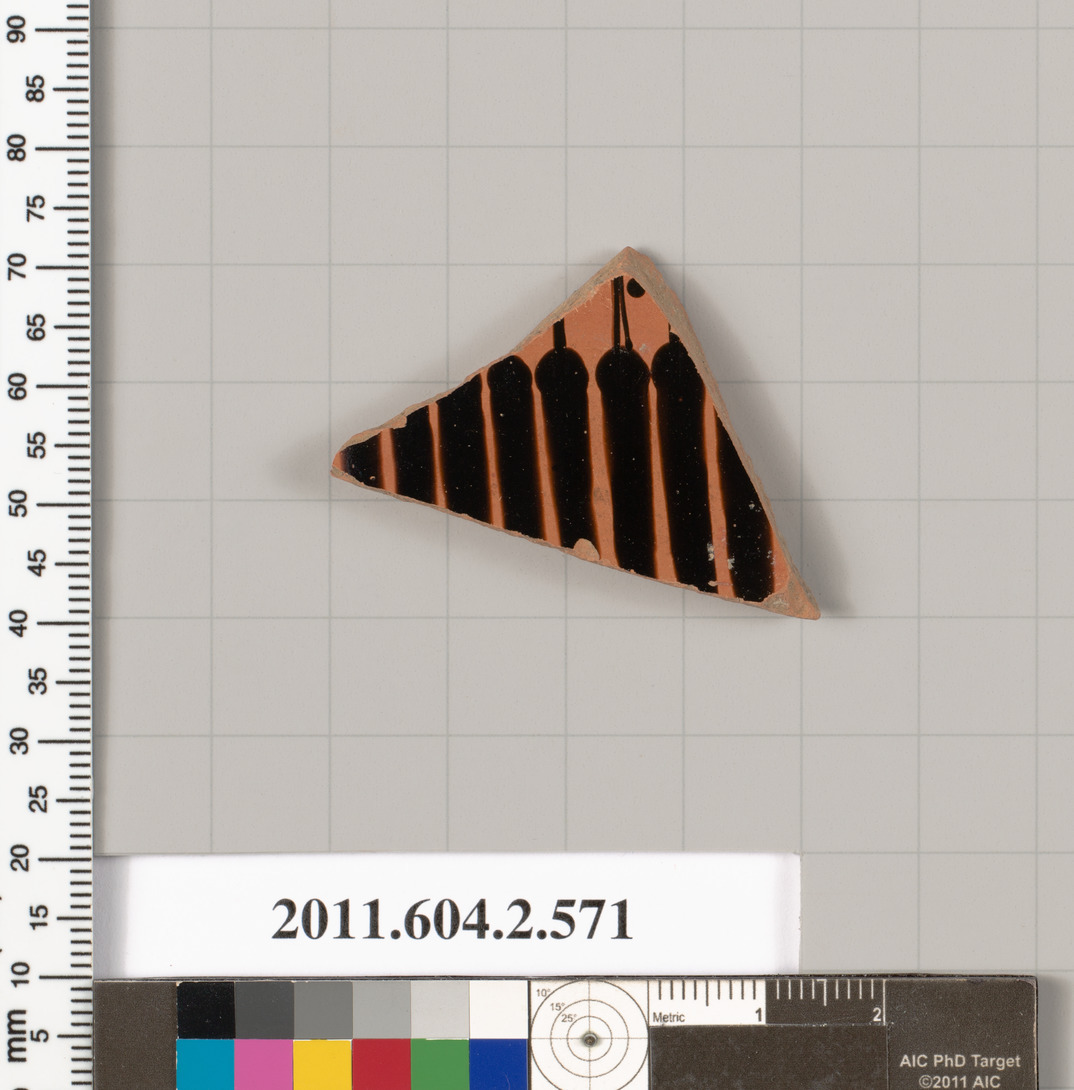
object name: column krater fragment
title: Terracotta fragment of a column-krater (bowl for mixing wine and water)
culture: greek, attic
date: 460-450 BCE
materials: terracotta